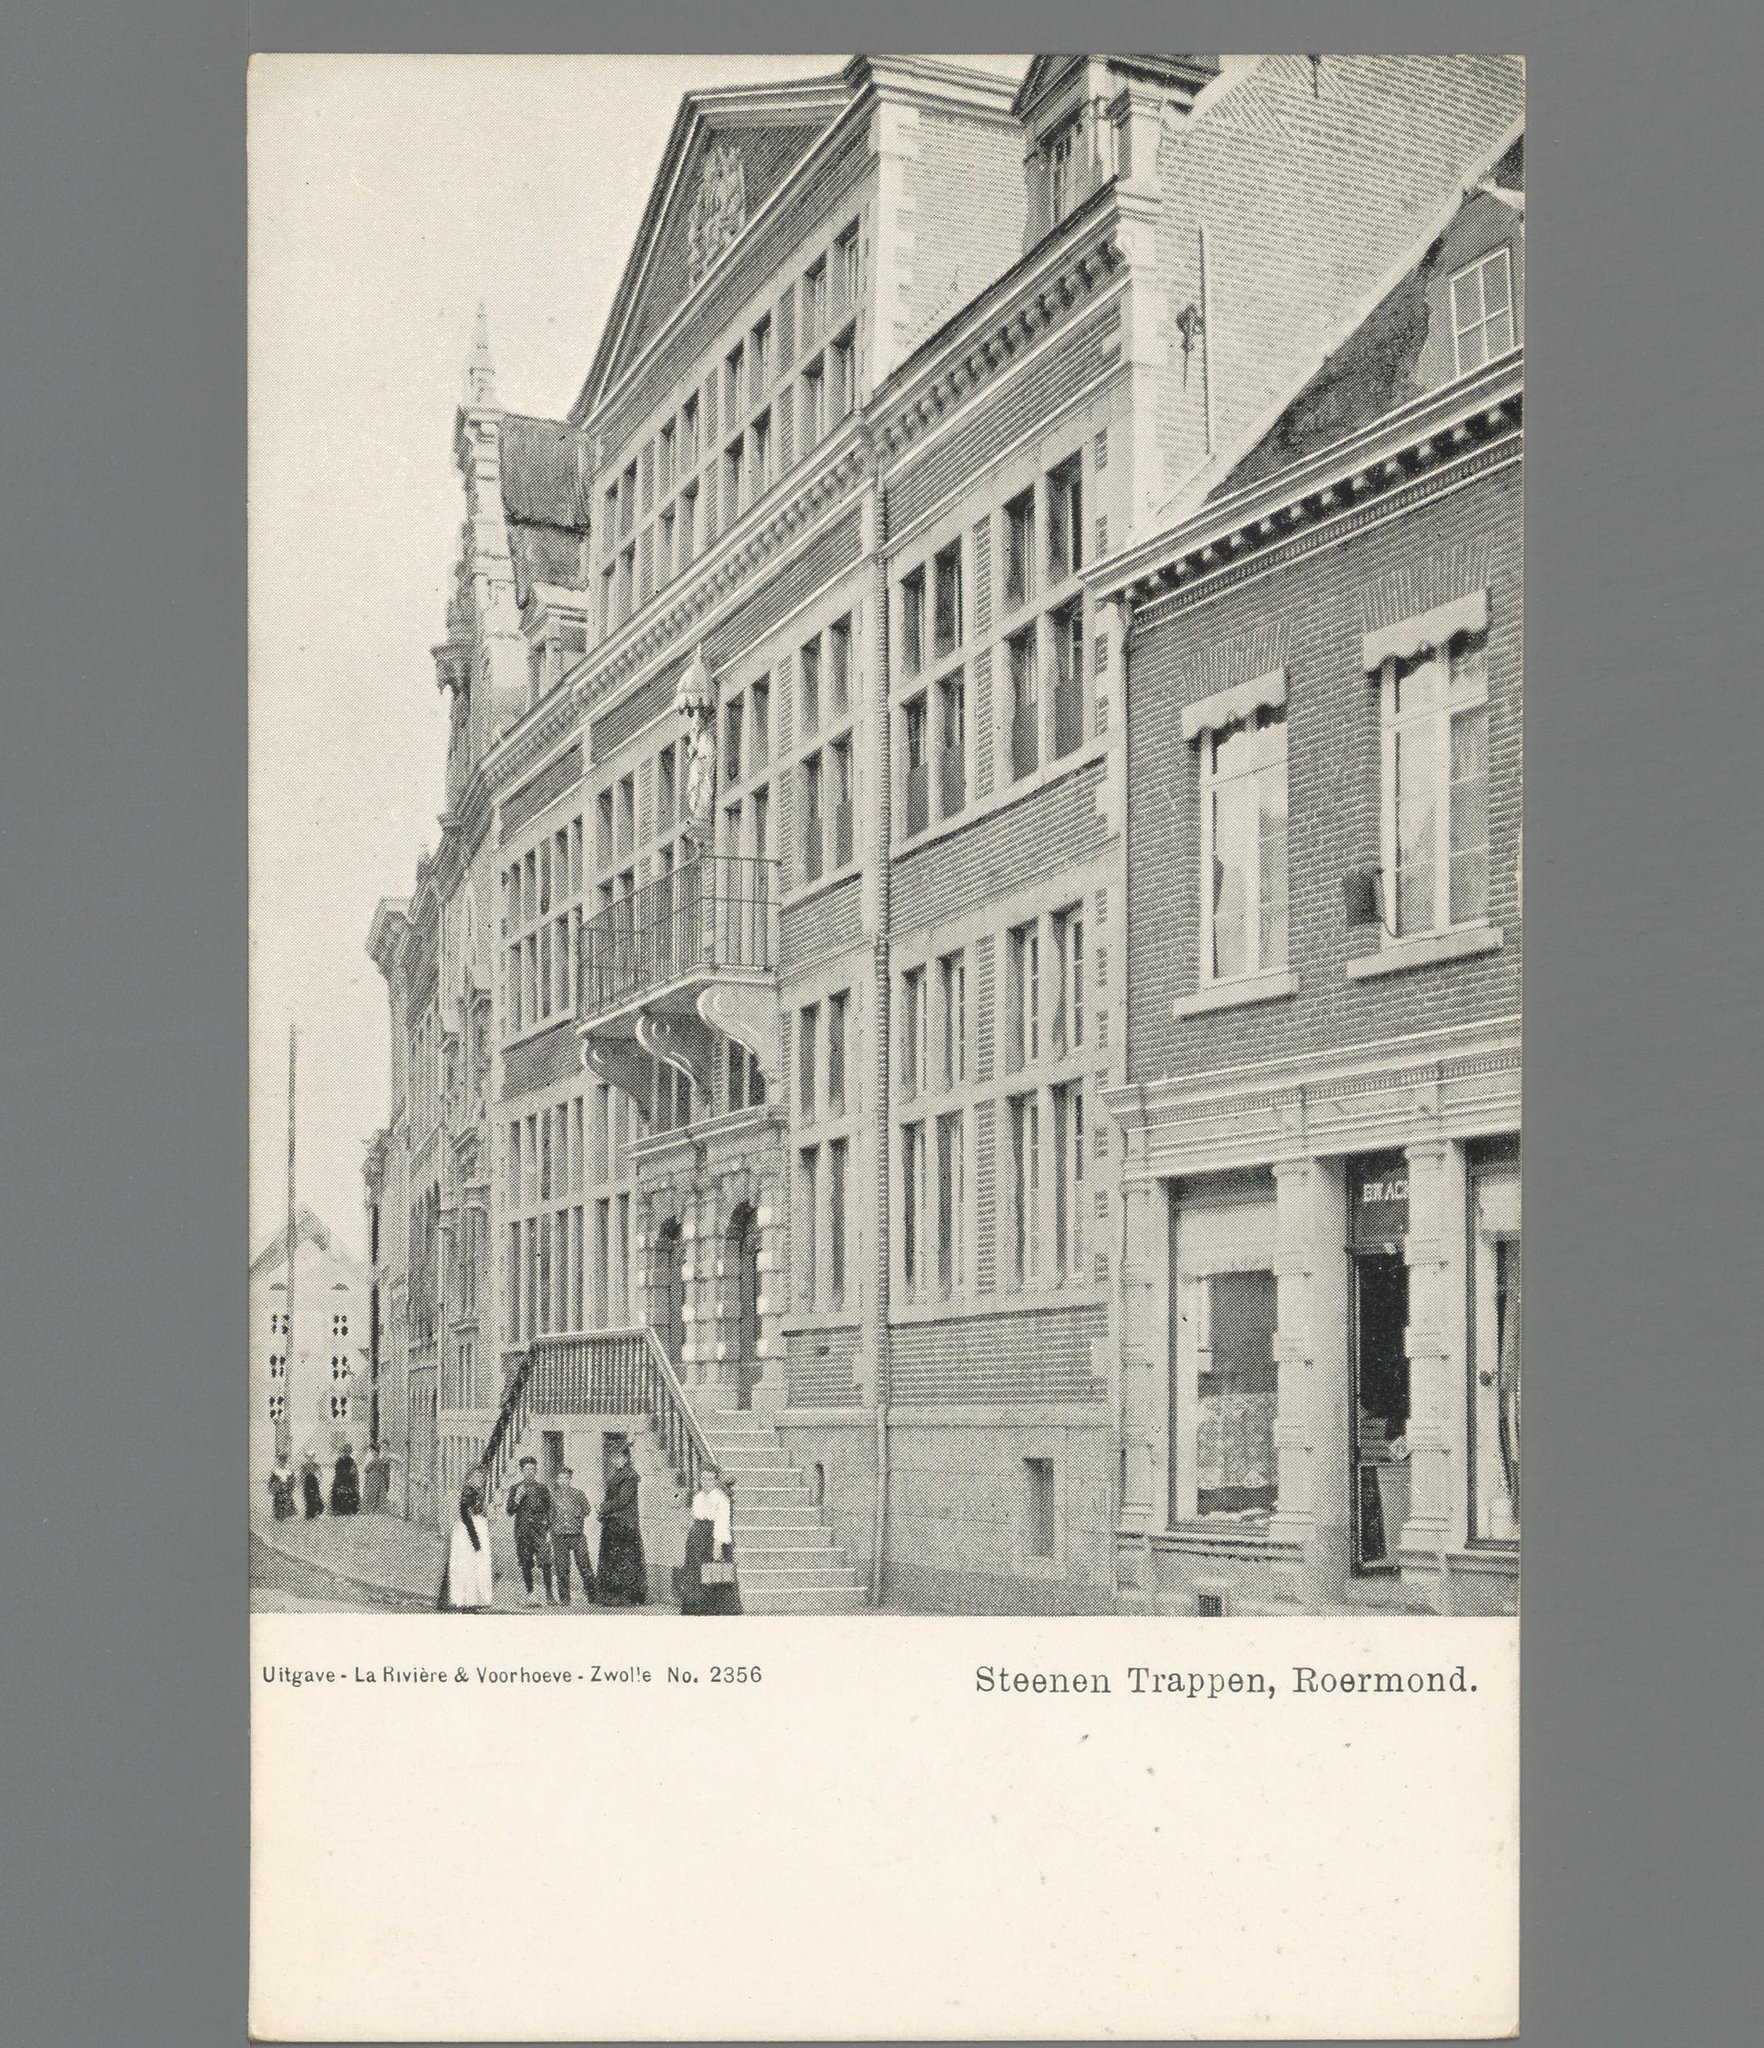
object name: ansichtkaart, prentbriefkaart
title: Steenen Trappen, Roermond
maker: Anonymous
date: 1897-1905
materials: cardboard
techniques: autotype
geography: zwolle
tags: urban housing, street